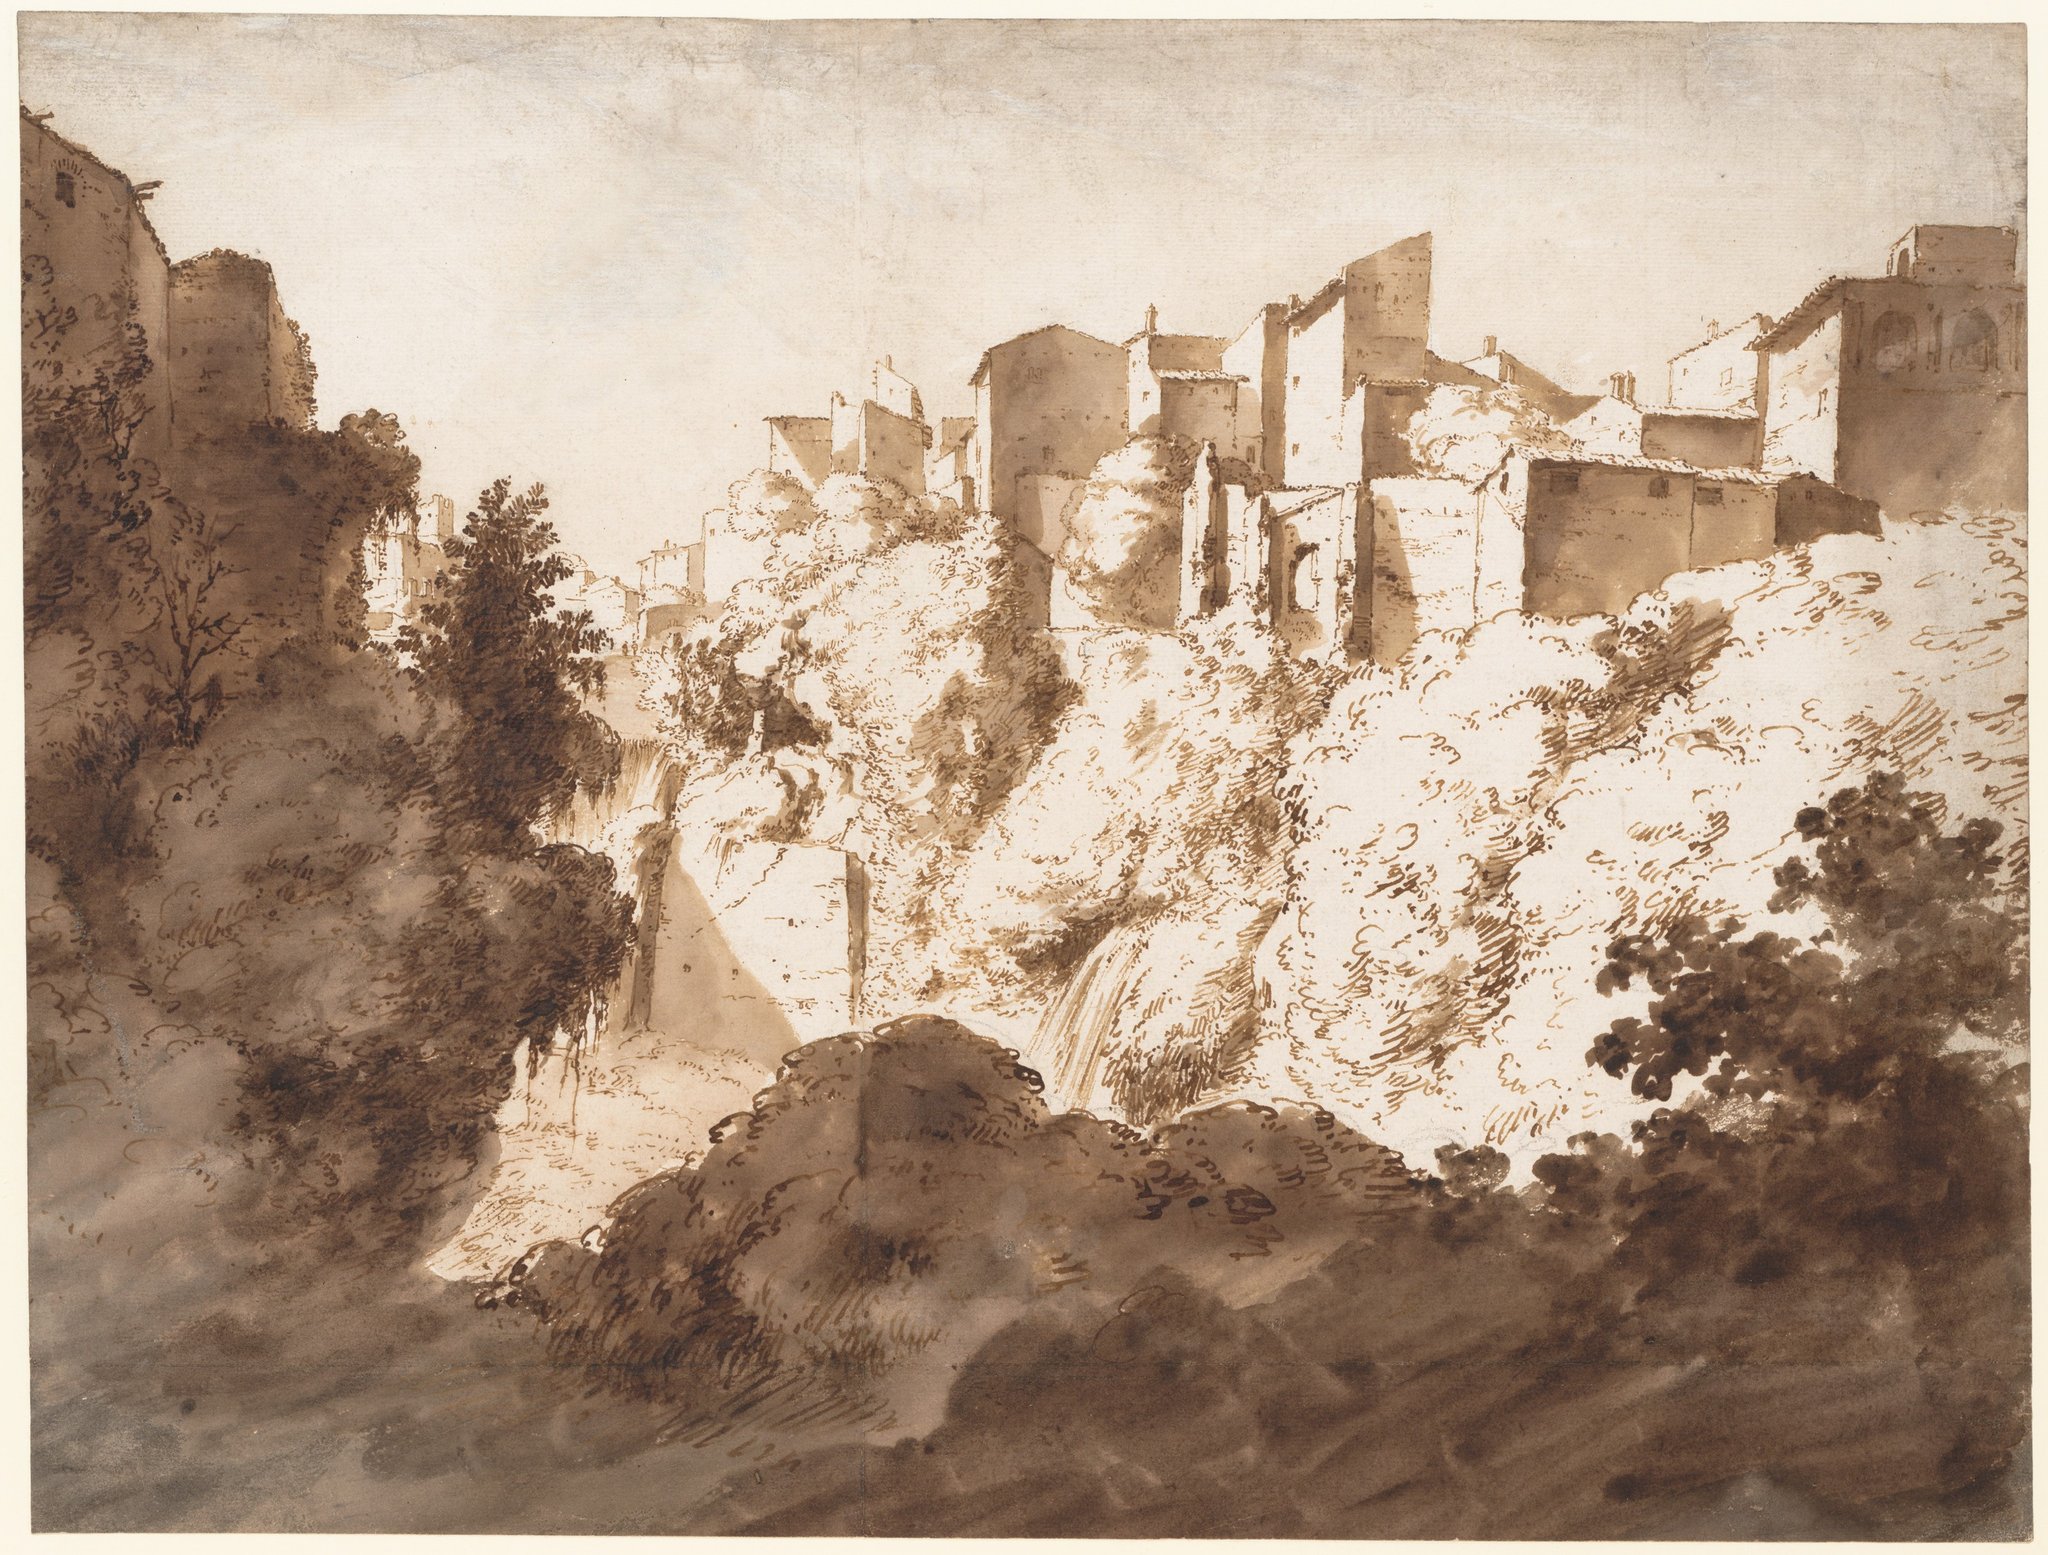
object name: drawing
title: View of Tivoli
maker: bartholomeus breenbergh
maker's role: artist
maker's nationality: dutch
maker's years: 1598-1657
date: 1601-1633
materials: chalk, ink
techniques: pen, wash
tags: buildings,trees